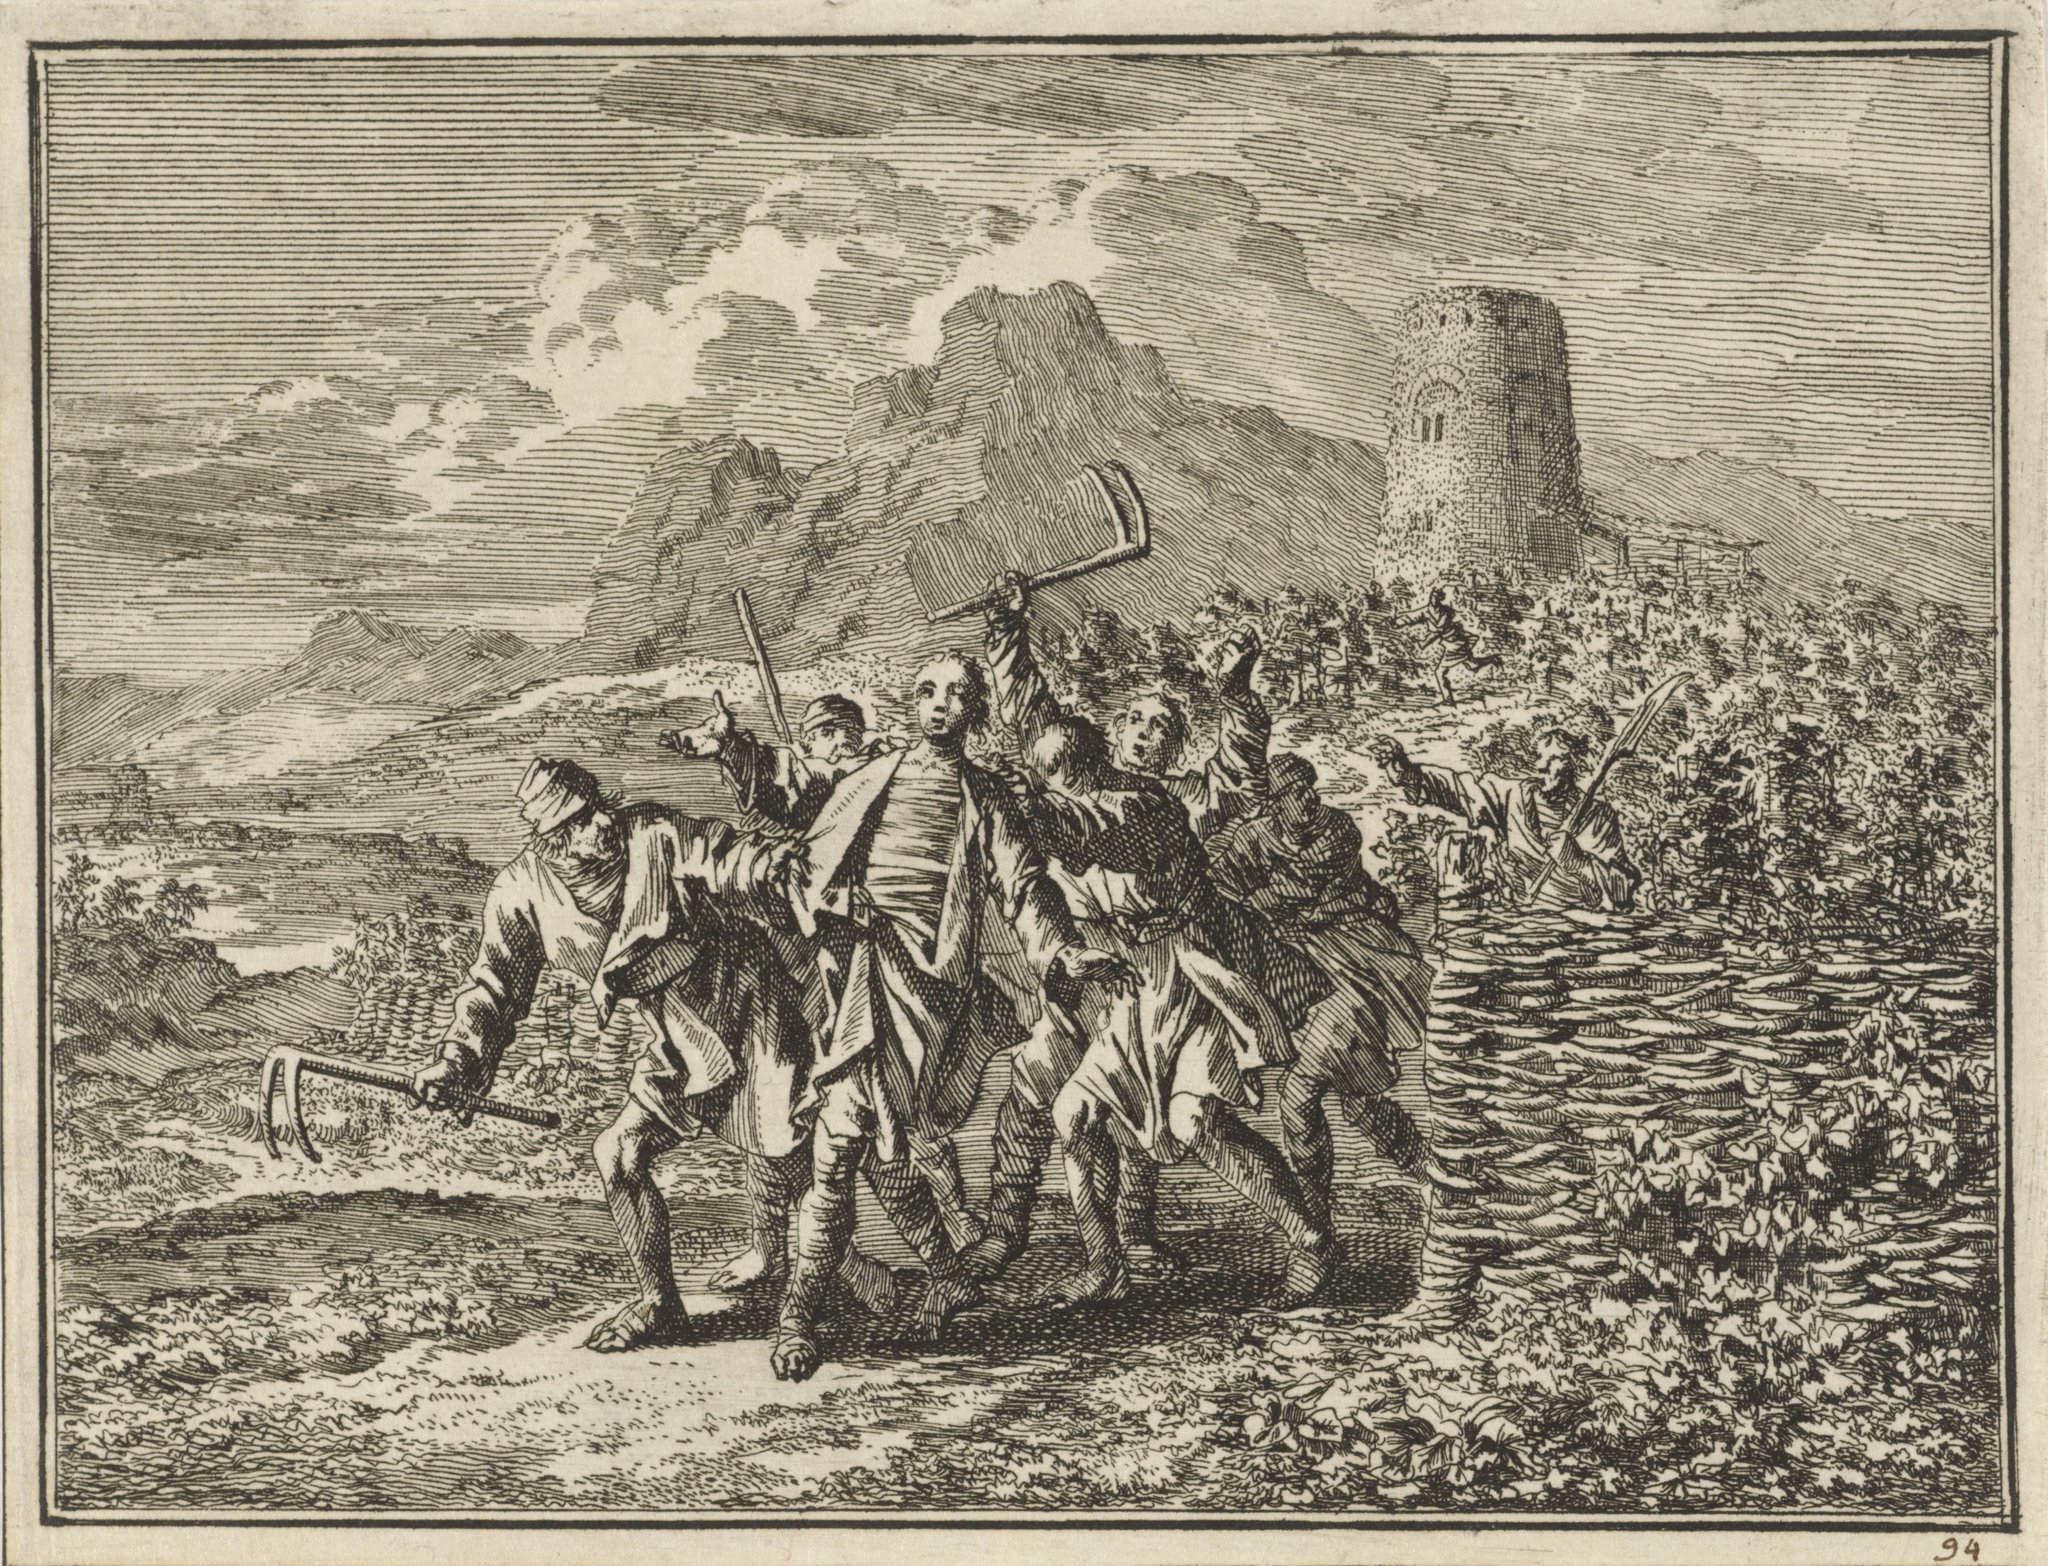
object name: print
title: Gelijkenis van de boze landlieden die de zoon van de eigenaar buiten de wijngaard werpen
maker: jan luyken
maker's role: draughtsman, print maker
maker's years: 1649-1712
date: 1712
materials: paper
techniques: etching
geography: amsterdam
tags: at last the lord sends his son, '... they cast him out of the vineyard, and killed him'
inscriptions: collector's mark: Lugt 2228, number: ‘94’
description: Proefdruk van illustratie uit: Luyken, Jan. De schriftuurlyke geschiedenissen en gelykenissen van het Oude en Nieuwe Verbond, 2 delen. Amsterdam: Wed. Pieter Arentsz II en Cornelis van der Sys, 1712, dl. II.